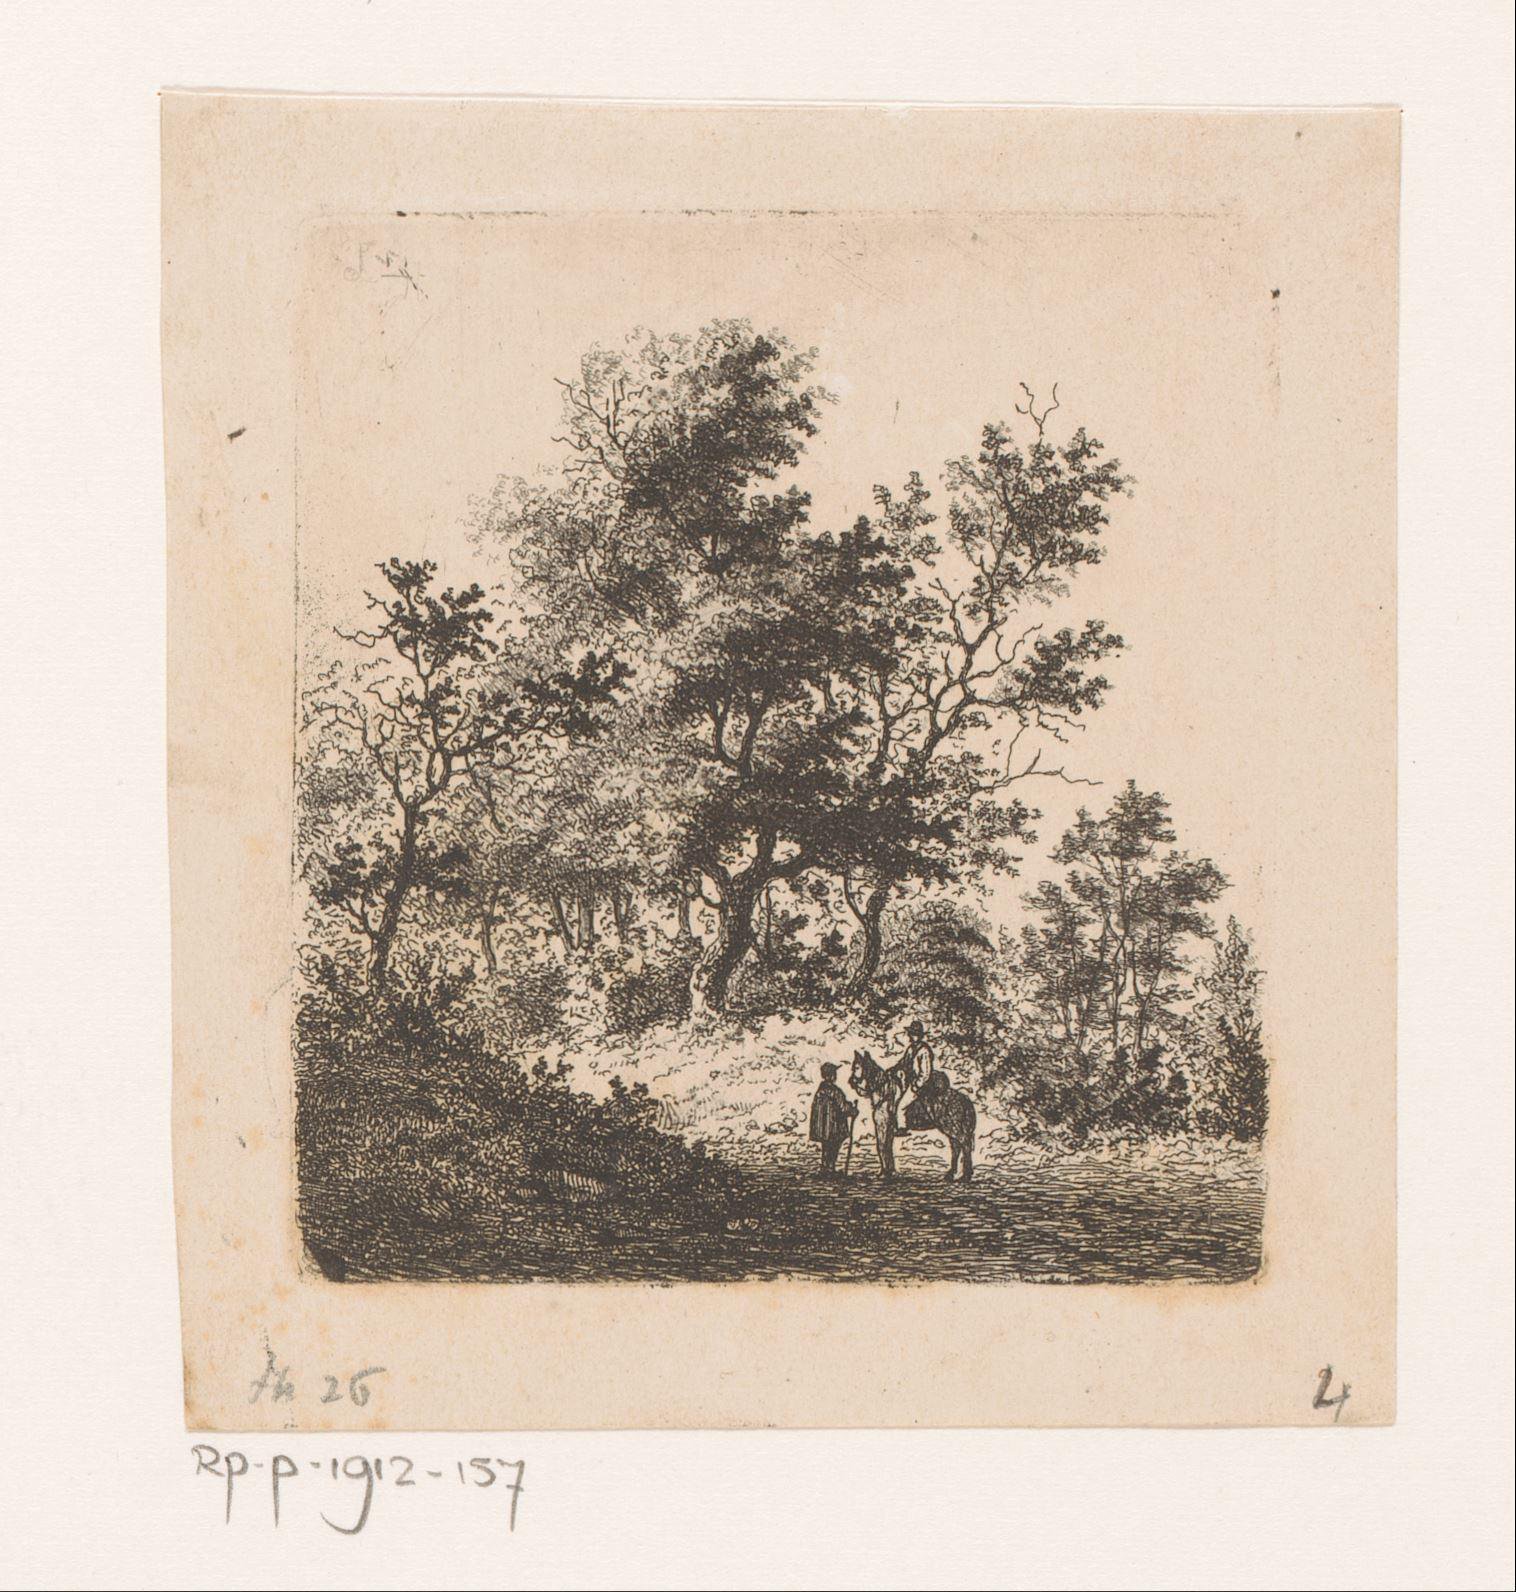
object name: print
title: Boslandschap bij Beert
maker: jean théodore joseph linnig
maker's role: draughtsman, print maker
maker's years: 1815-1891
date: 1848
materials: paper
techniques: etching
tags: forest path or lane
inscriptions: collector's mark: Lugt 1485, collector's mark: Lugt 2228